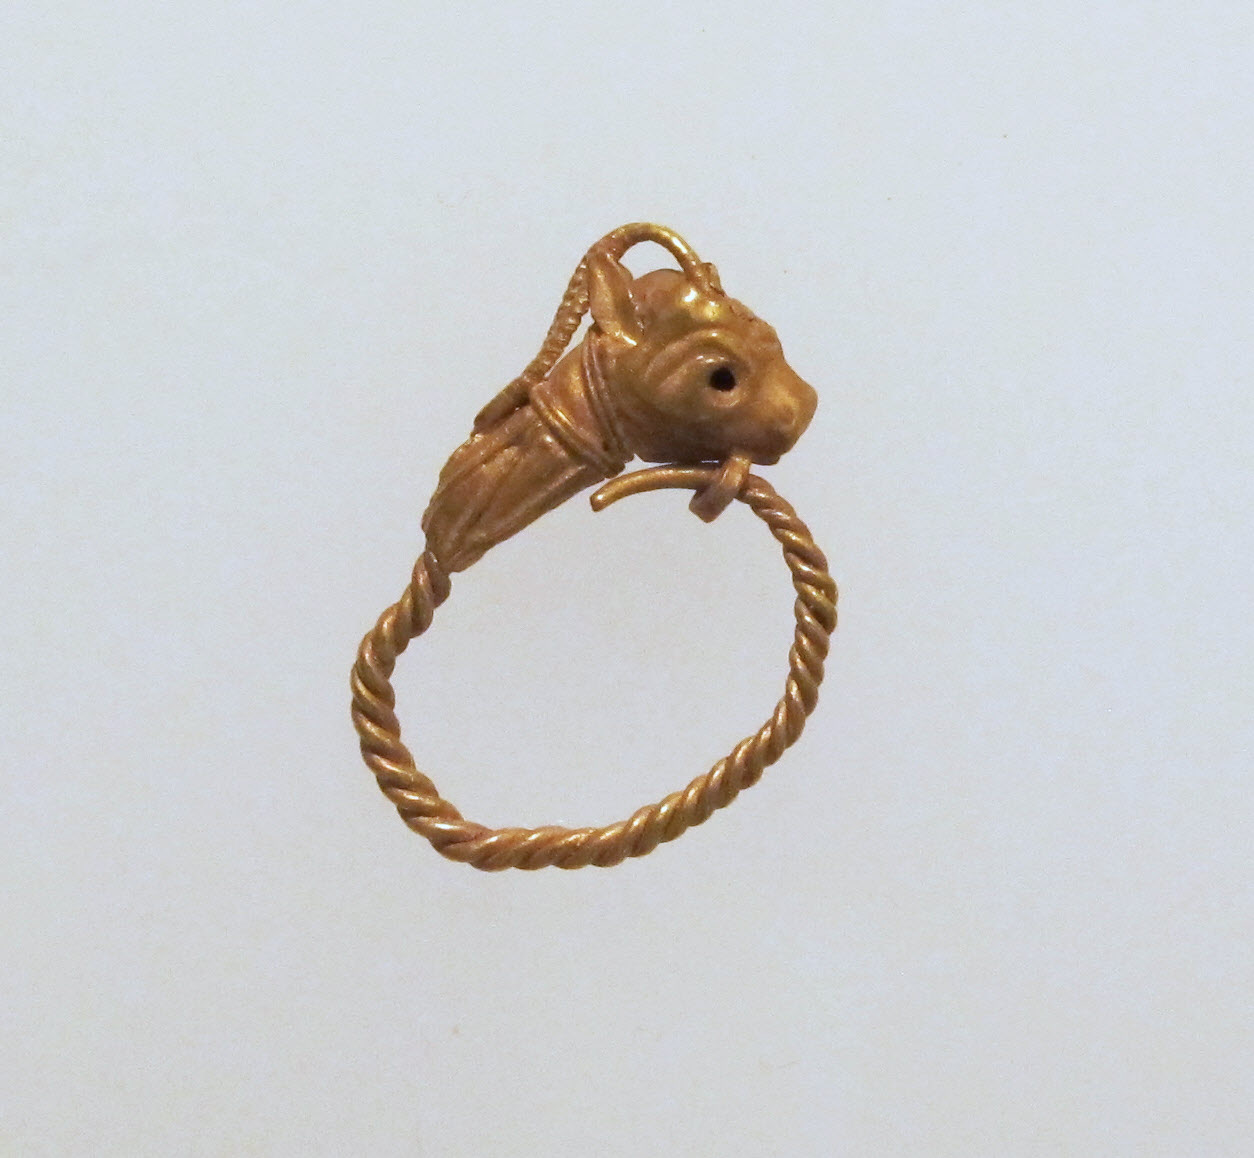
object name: earring with head of animal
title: Gold earring with head of an animal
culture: greek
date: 400-201 BCE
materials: gold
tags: animals